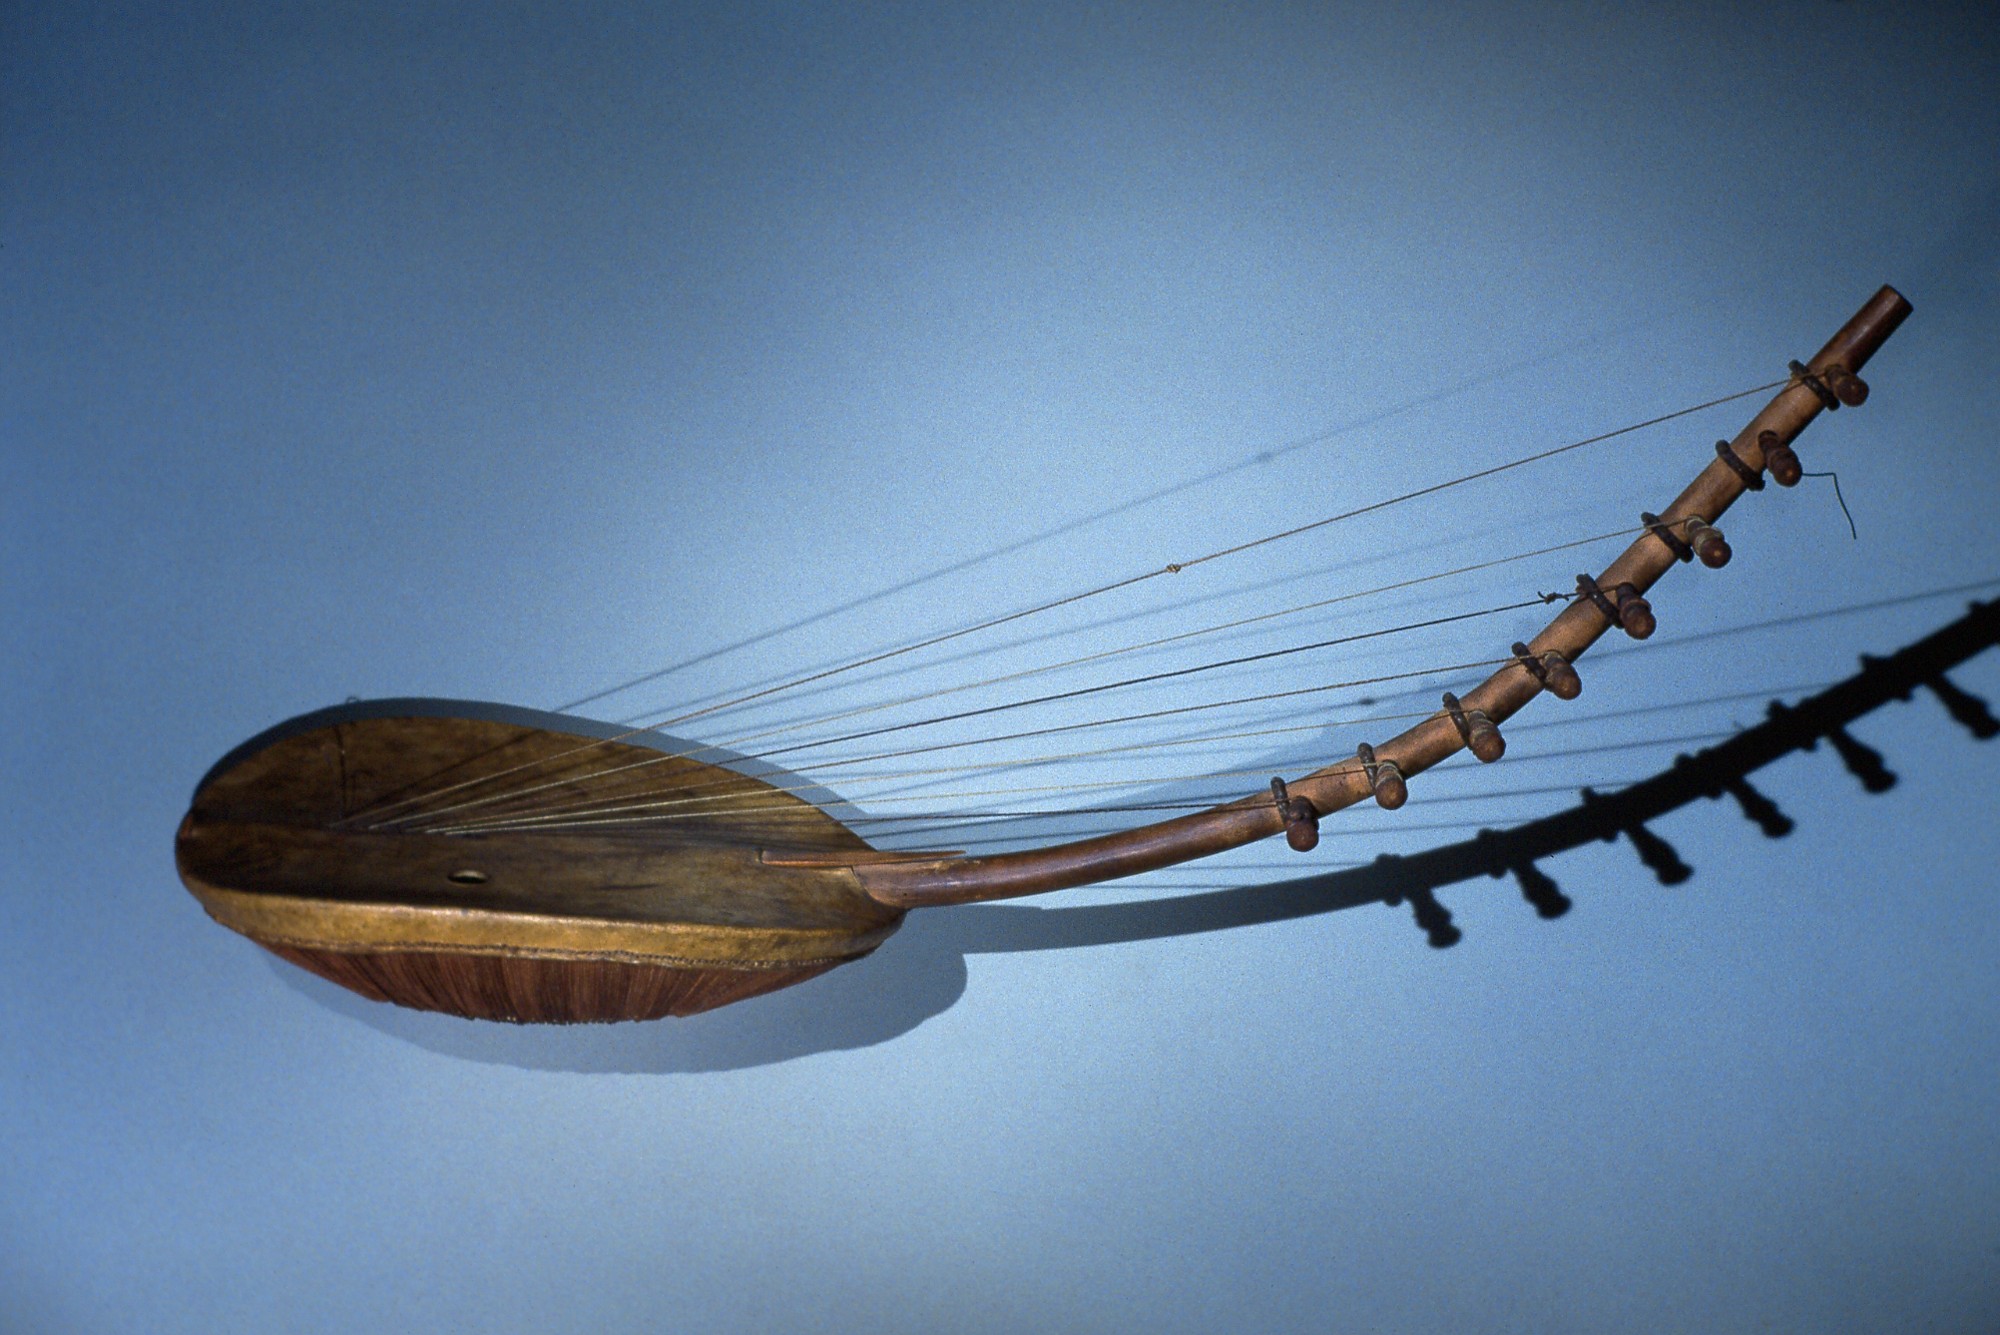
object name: ennanga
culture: ganda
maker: ganda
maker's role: culture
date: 1801-1900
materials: fiber, skin, wood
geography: uganda